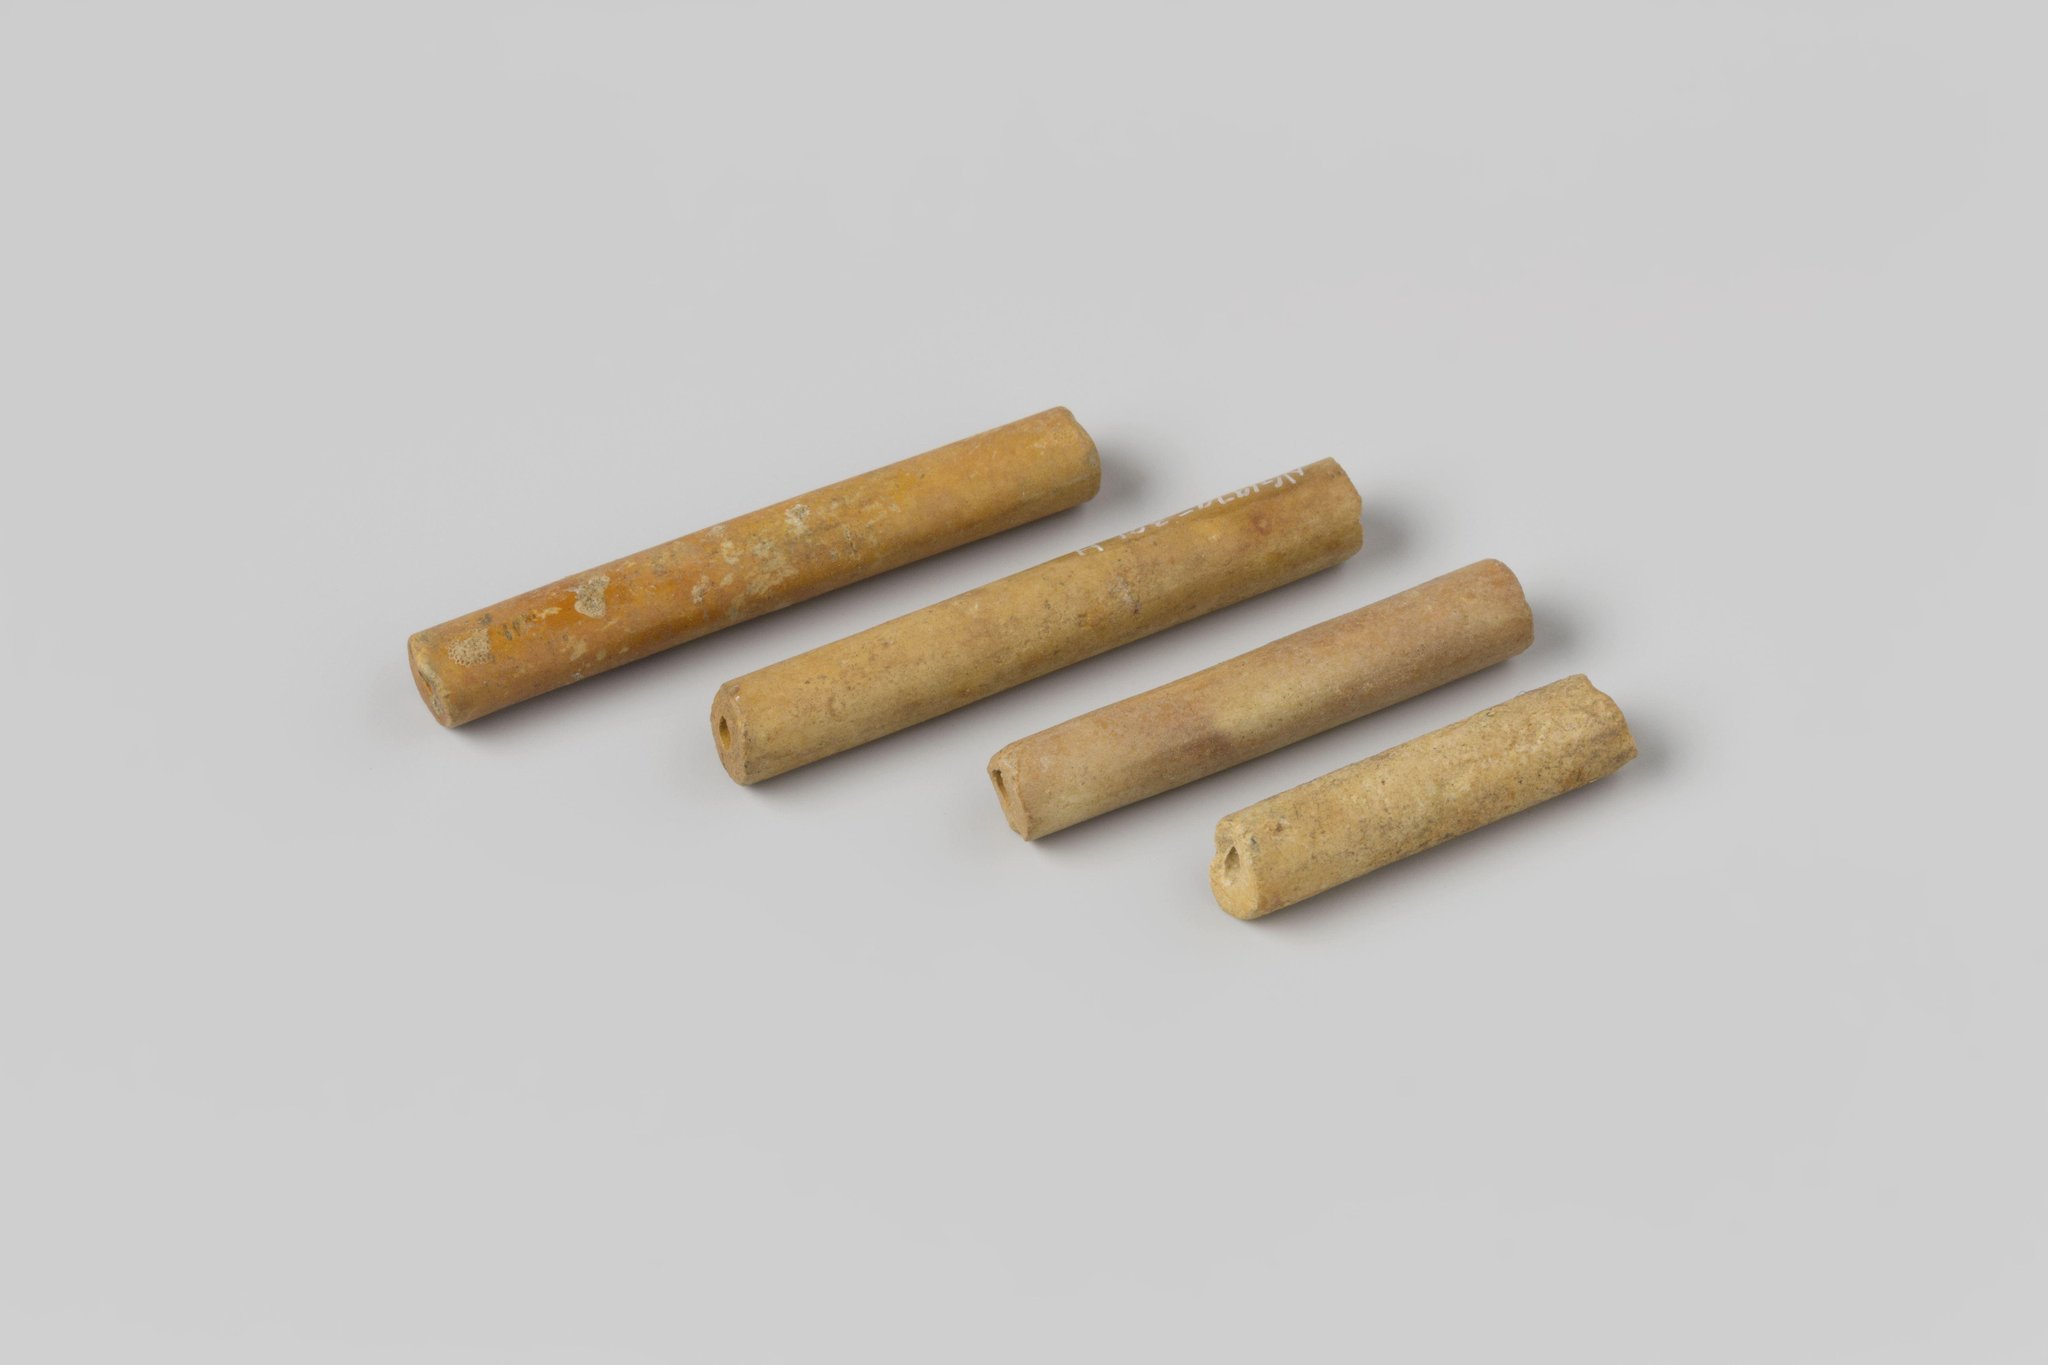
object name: pipe stem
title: Fragmenten pijpenstelen uit het wrak van de Oost-Indiëvaarder Hollandia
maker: Anonymous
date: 1700-1743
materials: clay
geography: netherlands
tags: verenigde oostindische compagnie, hollandia (schip), annet